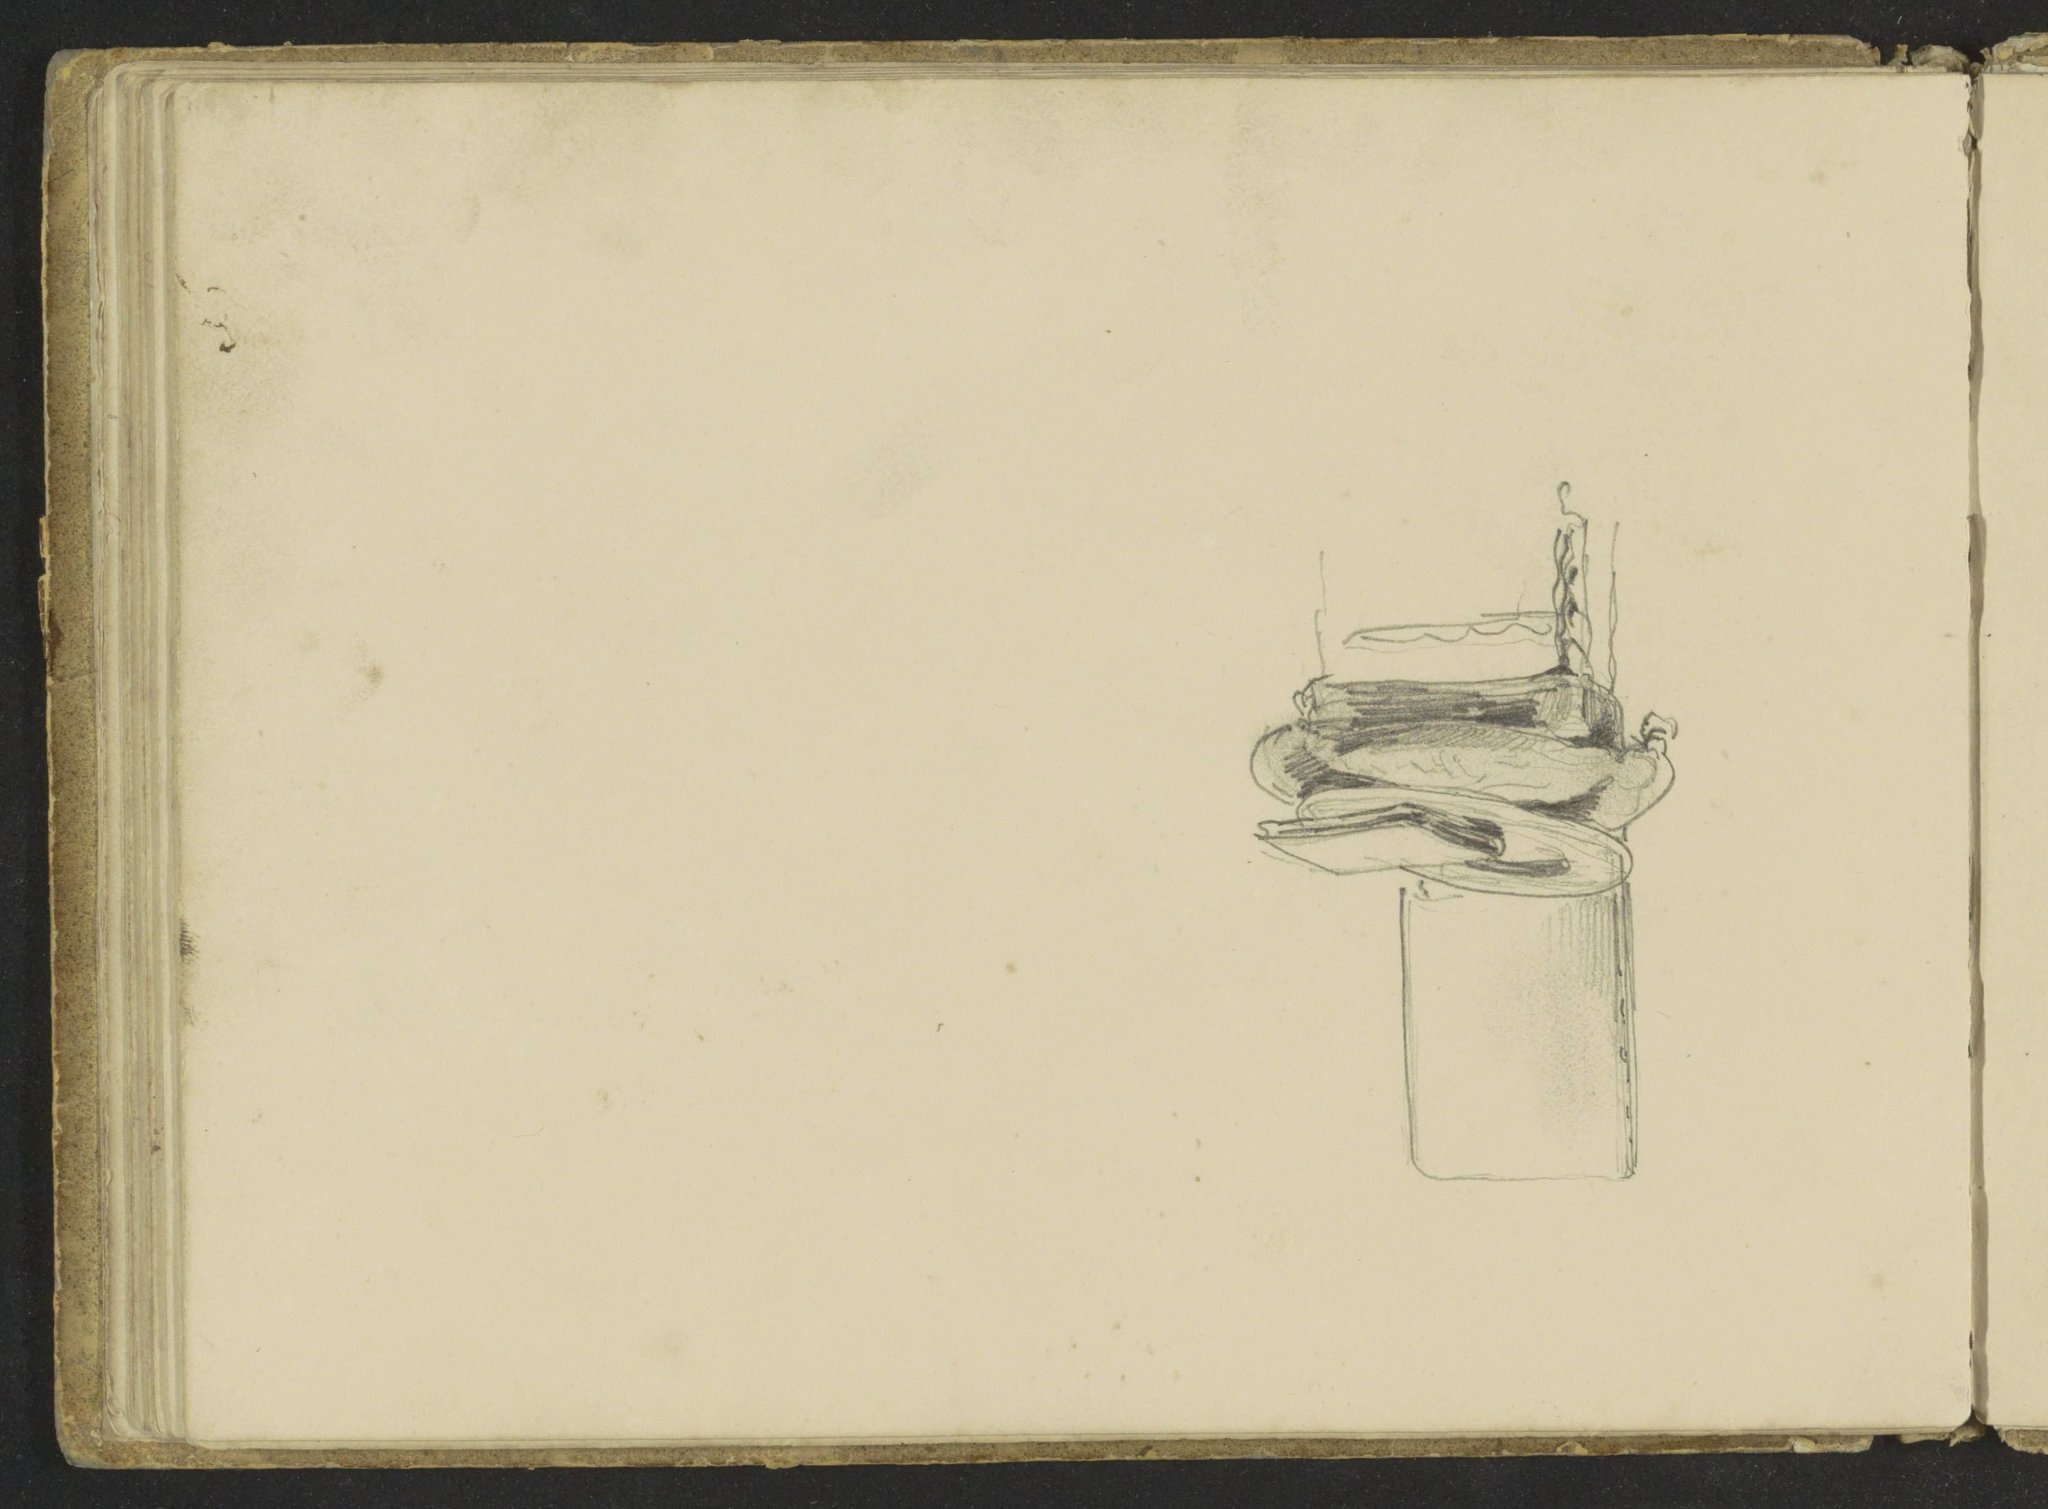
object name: sketchbook leaf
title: Schaal en boek op een stoel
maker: willem hendrik schmidt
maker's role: draughtsman, painter, print maker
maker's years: 1809-1849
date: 1819-1849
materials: paper, pencil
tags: table, book, bowl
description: Blad 27 verso uit een schetsboek met 36 bladen.